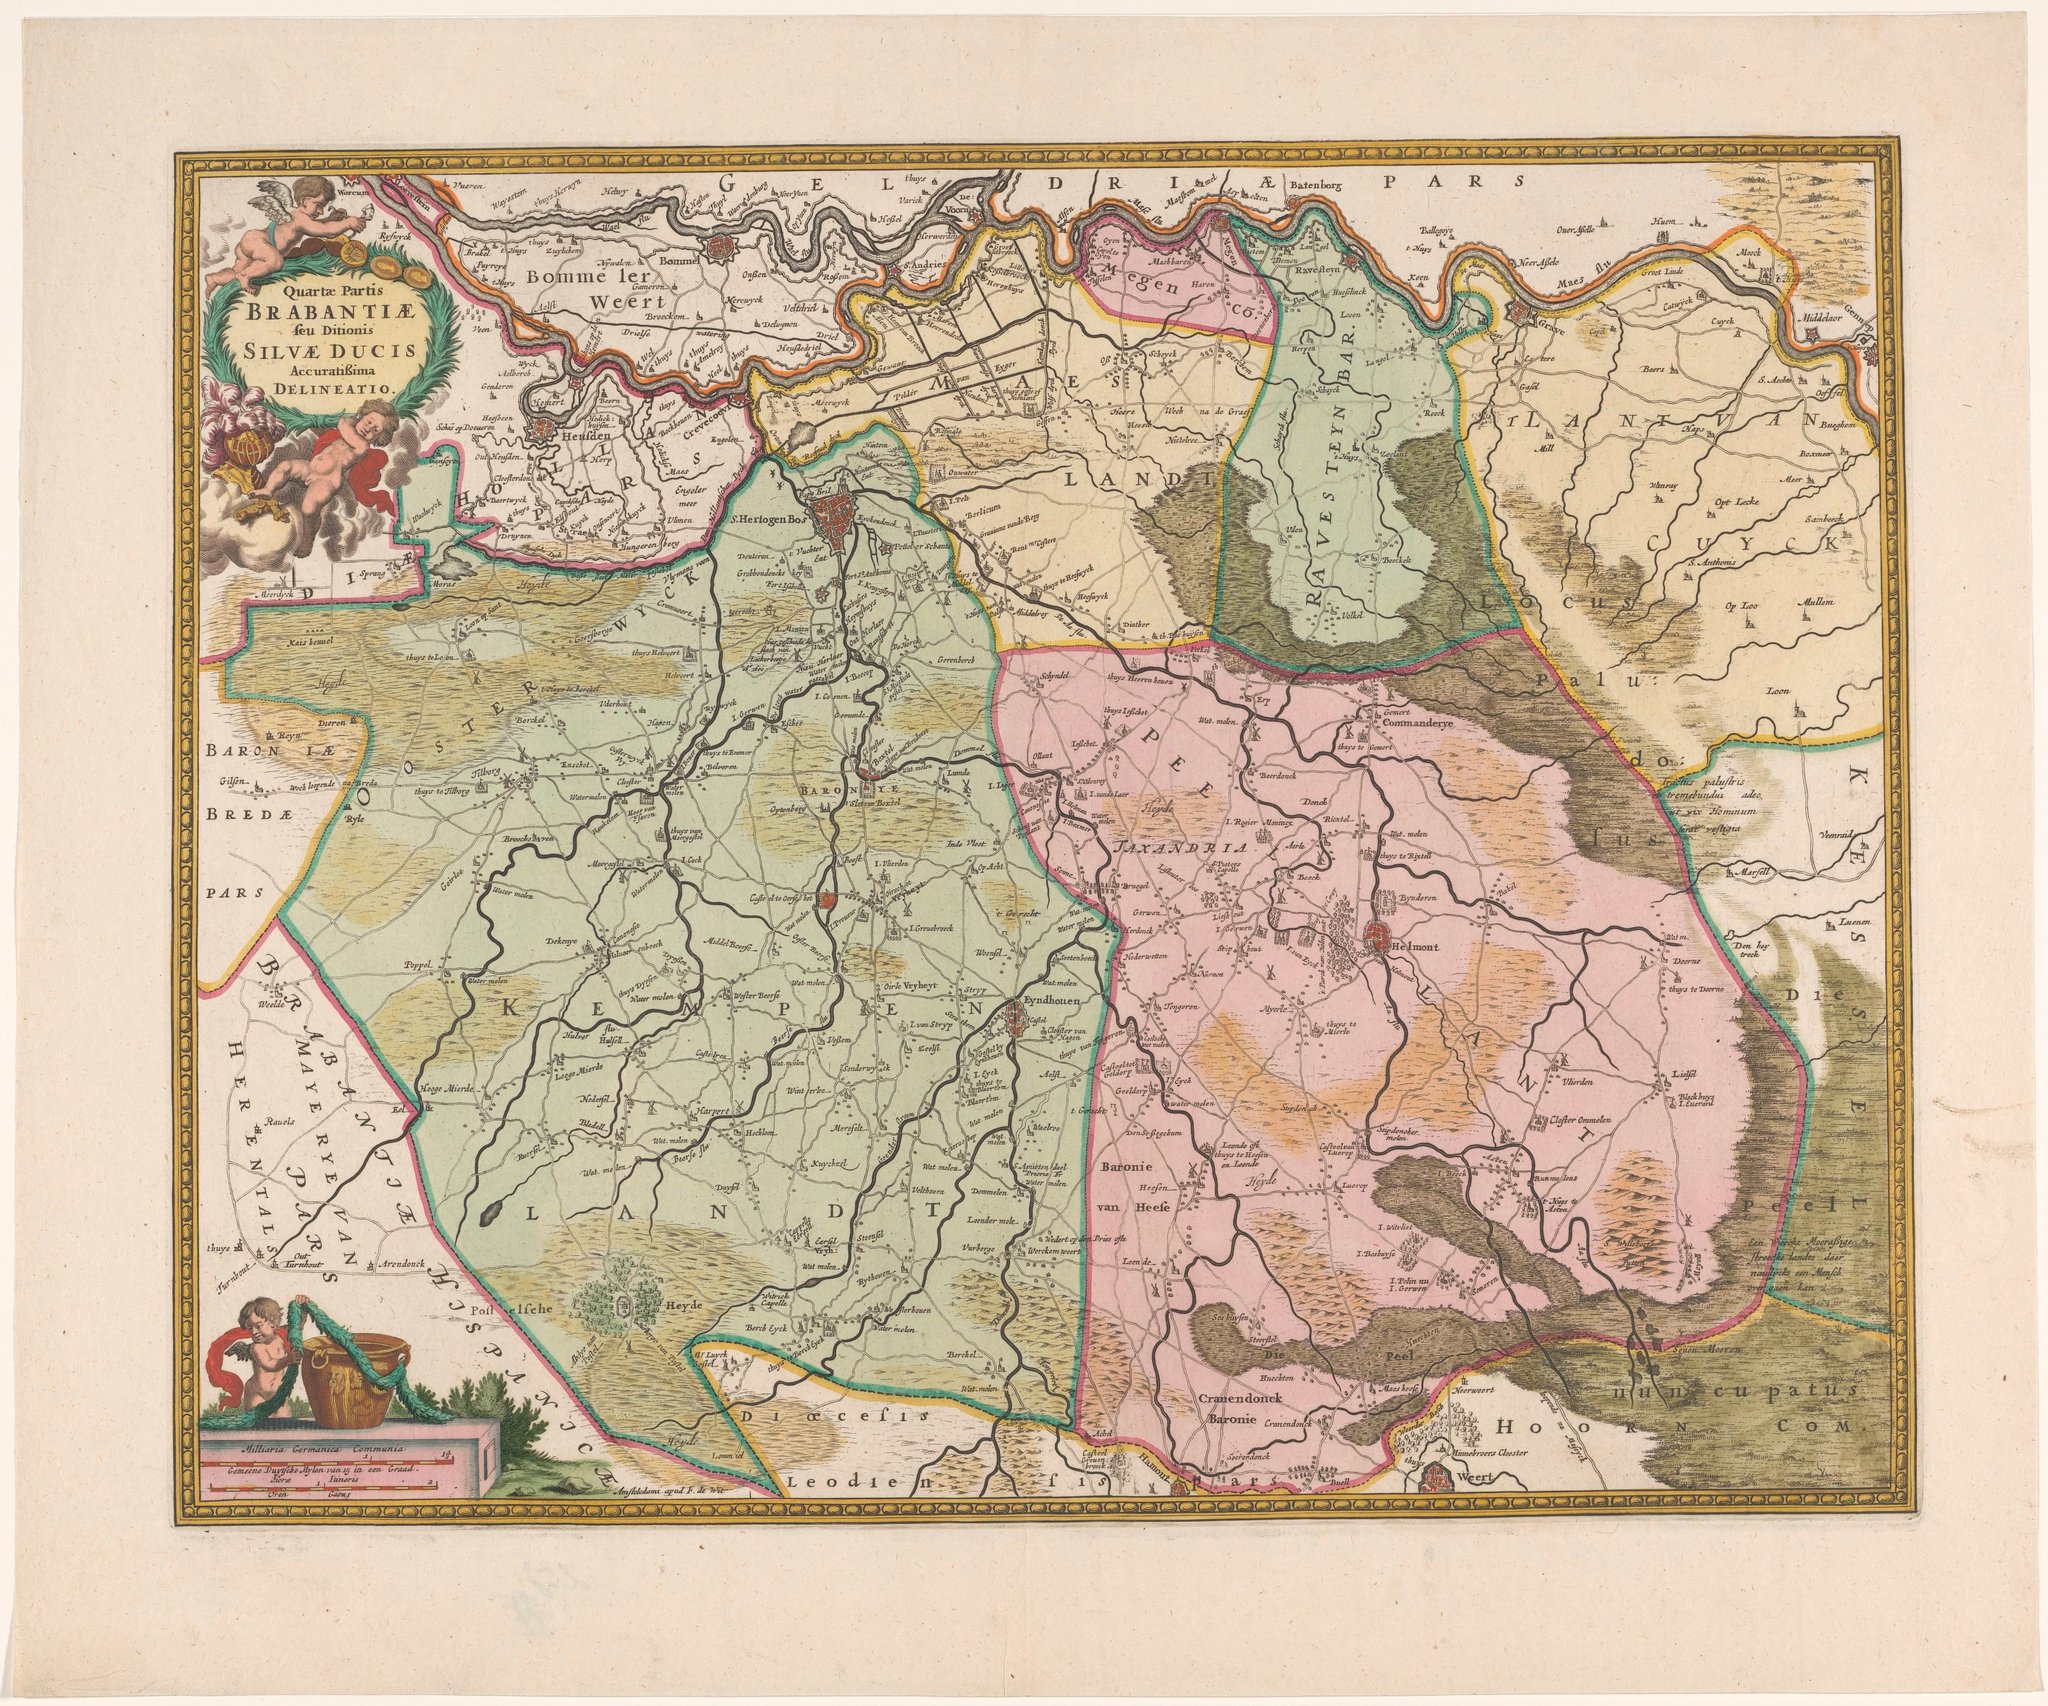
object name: print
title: Quartae partis Brabantiae seu ditionis Silvae Ducis accuratissima delineatio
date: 1633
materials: paper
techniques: engraving, etching, hand coloring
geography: amsterdam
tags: maps of separate countries or regions, den bosch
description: Prent ook gebruikt in verschillende atlassen van De Wit. Uit welke atlas deze kaart precies komt, is niet na te gaan. De eerste staat van deze prent is gebruikt in verschillende atlassen van Hondius en Janssonius.